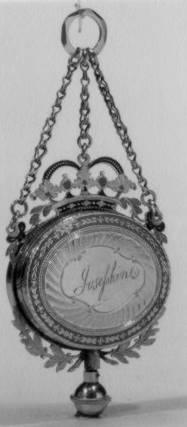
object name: music box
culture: french or swiss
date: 1815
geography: france